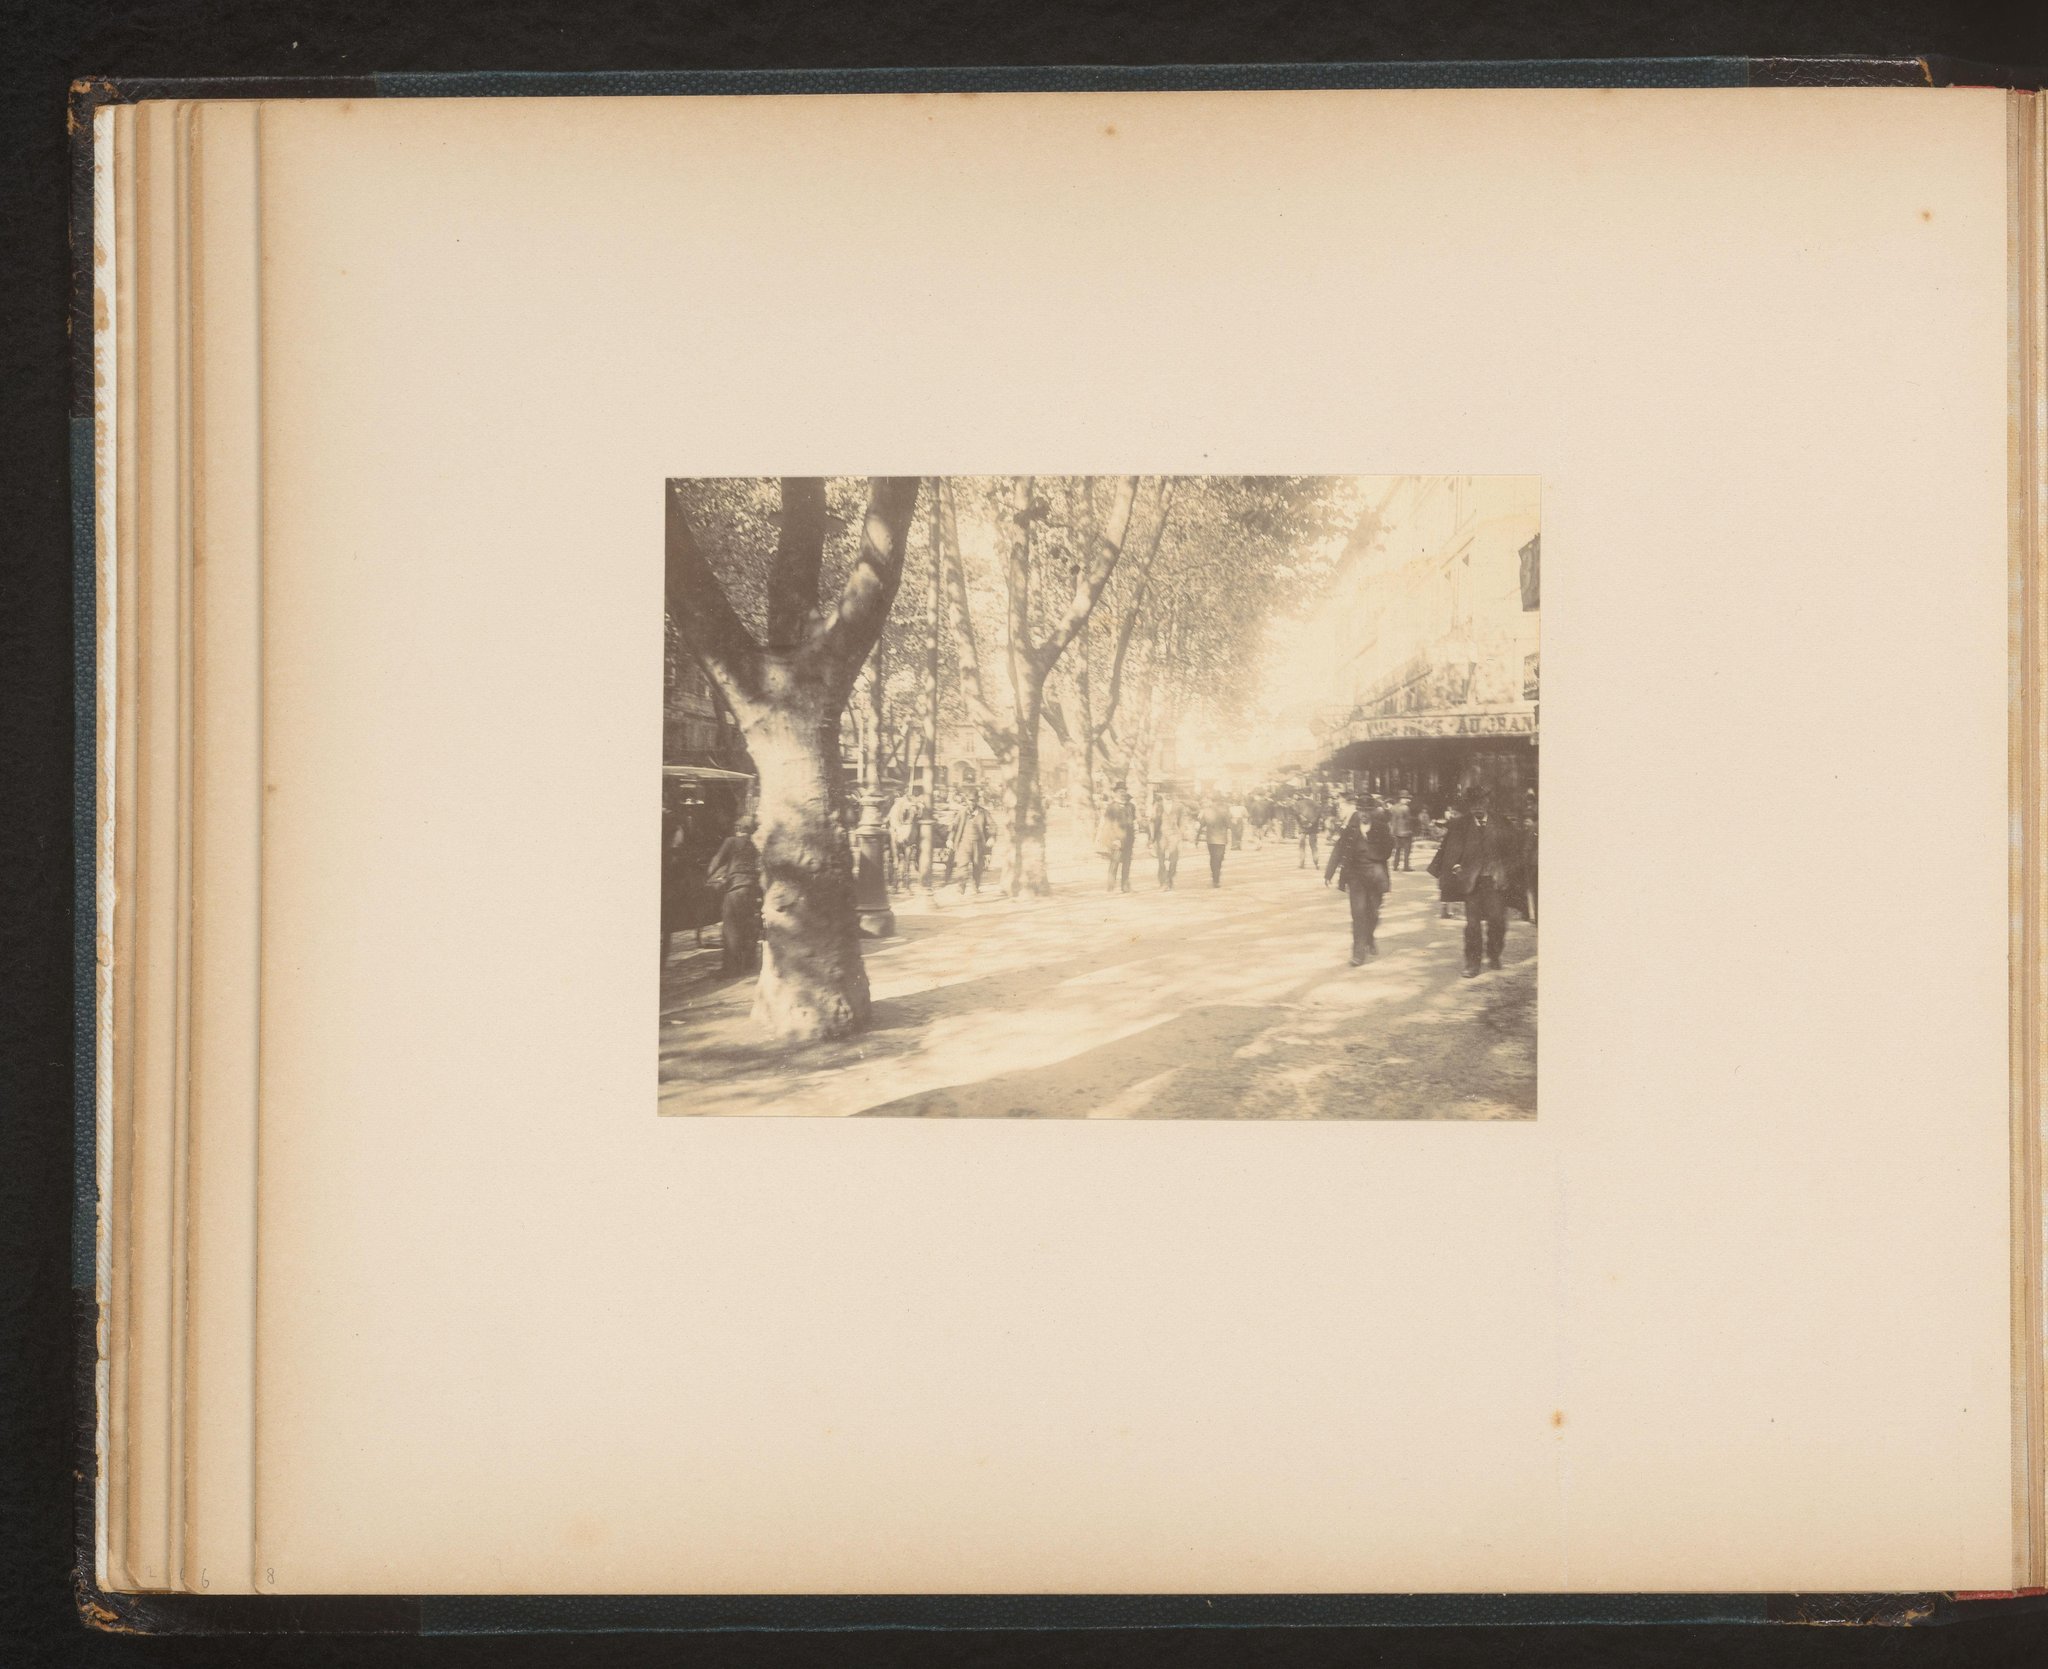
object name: photograph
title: Straatgezicht te Frankrijk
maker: Anonymous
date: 1880-1920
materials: cardboard, photographic support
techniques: gelatin silver print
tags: trees, historical persons, street, france